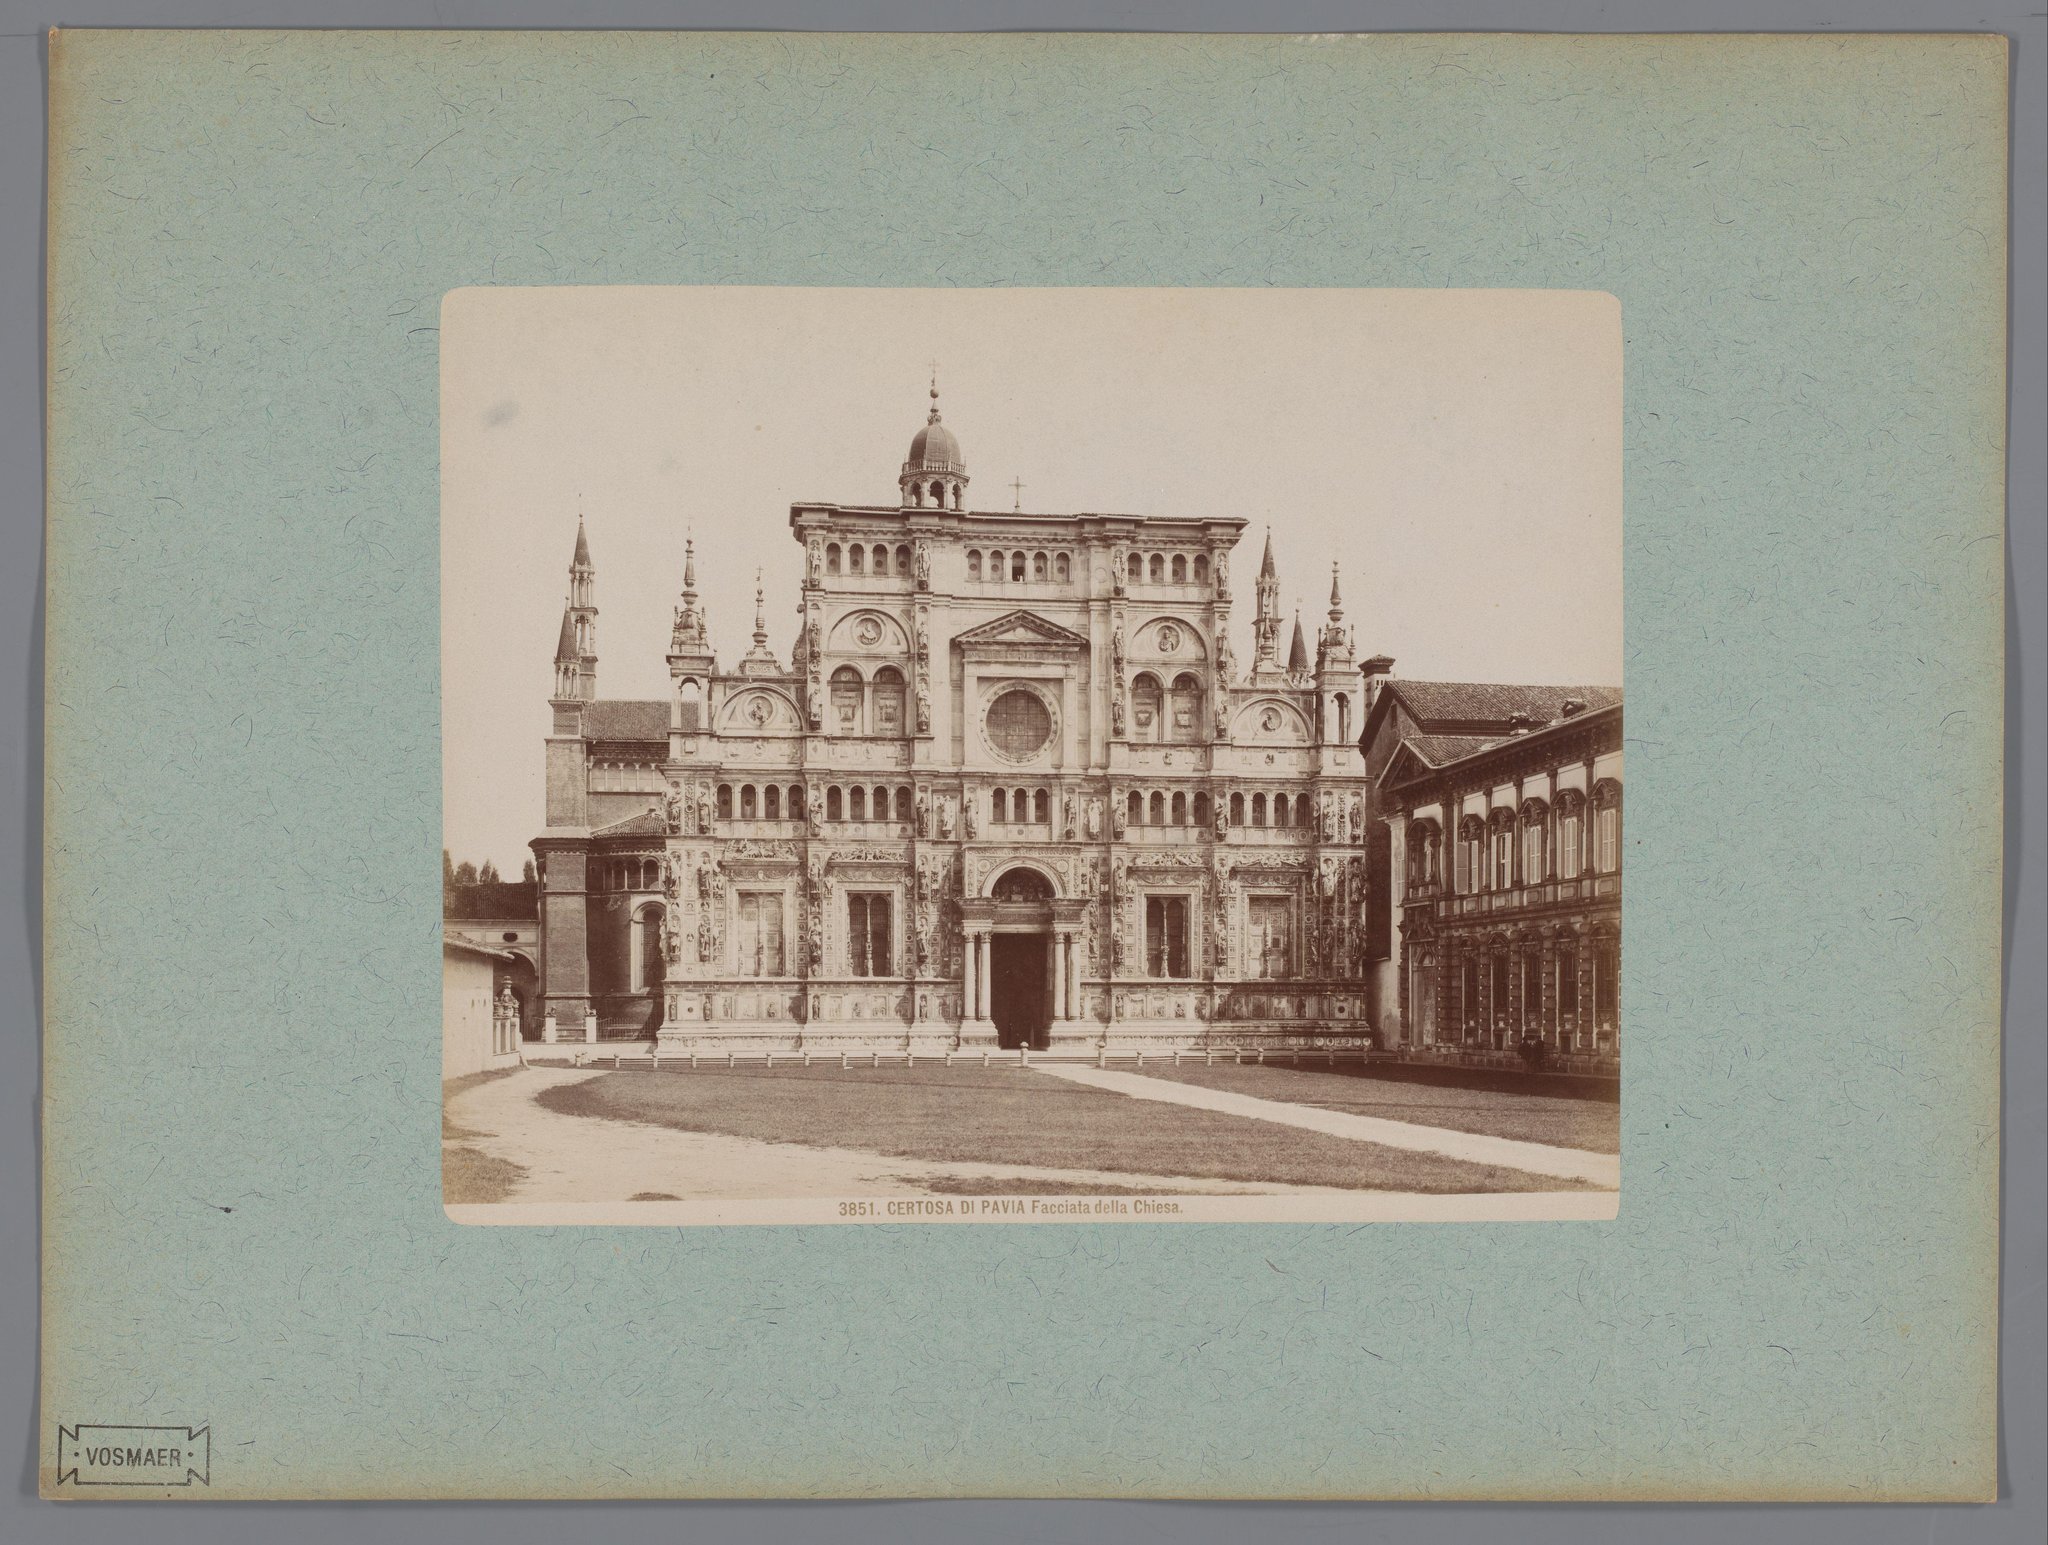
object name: photograph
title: Certosa di Pavia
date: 1856-1881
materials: cardboard, paper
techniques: albumen print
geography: pavia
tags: abbey, monastery, convent ~ roman catholic church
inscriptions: collector's mark: ‘VOSMAER’, number: ‘3851.’